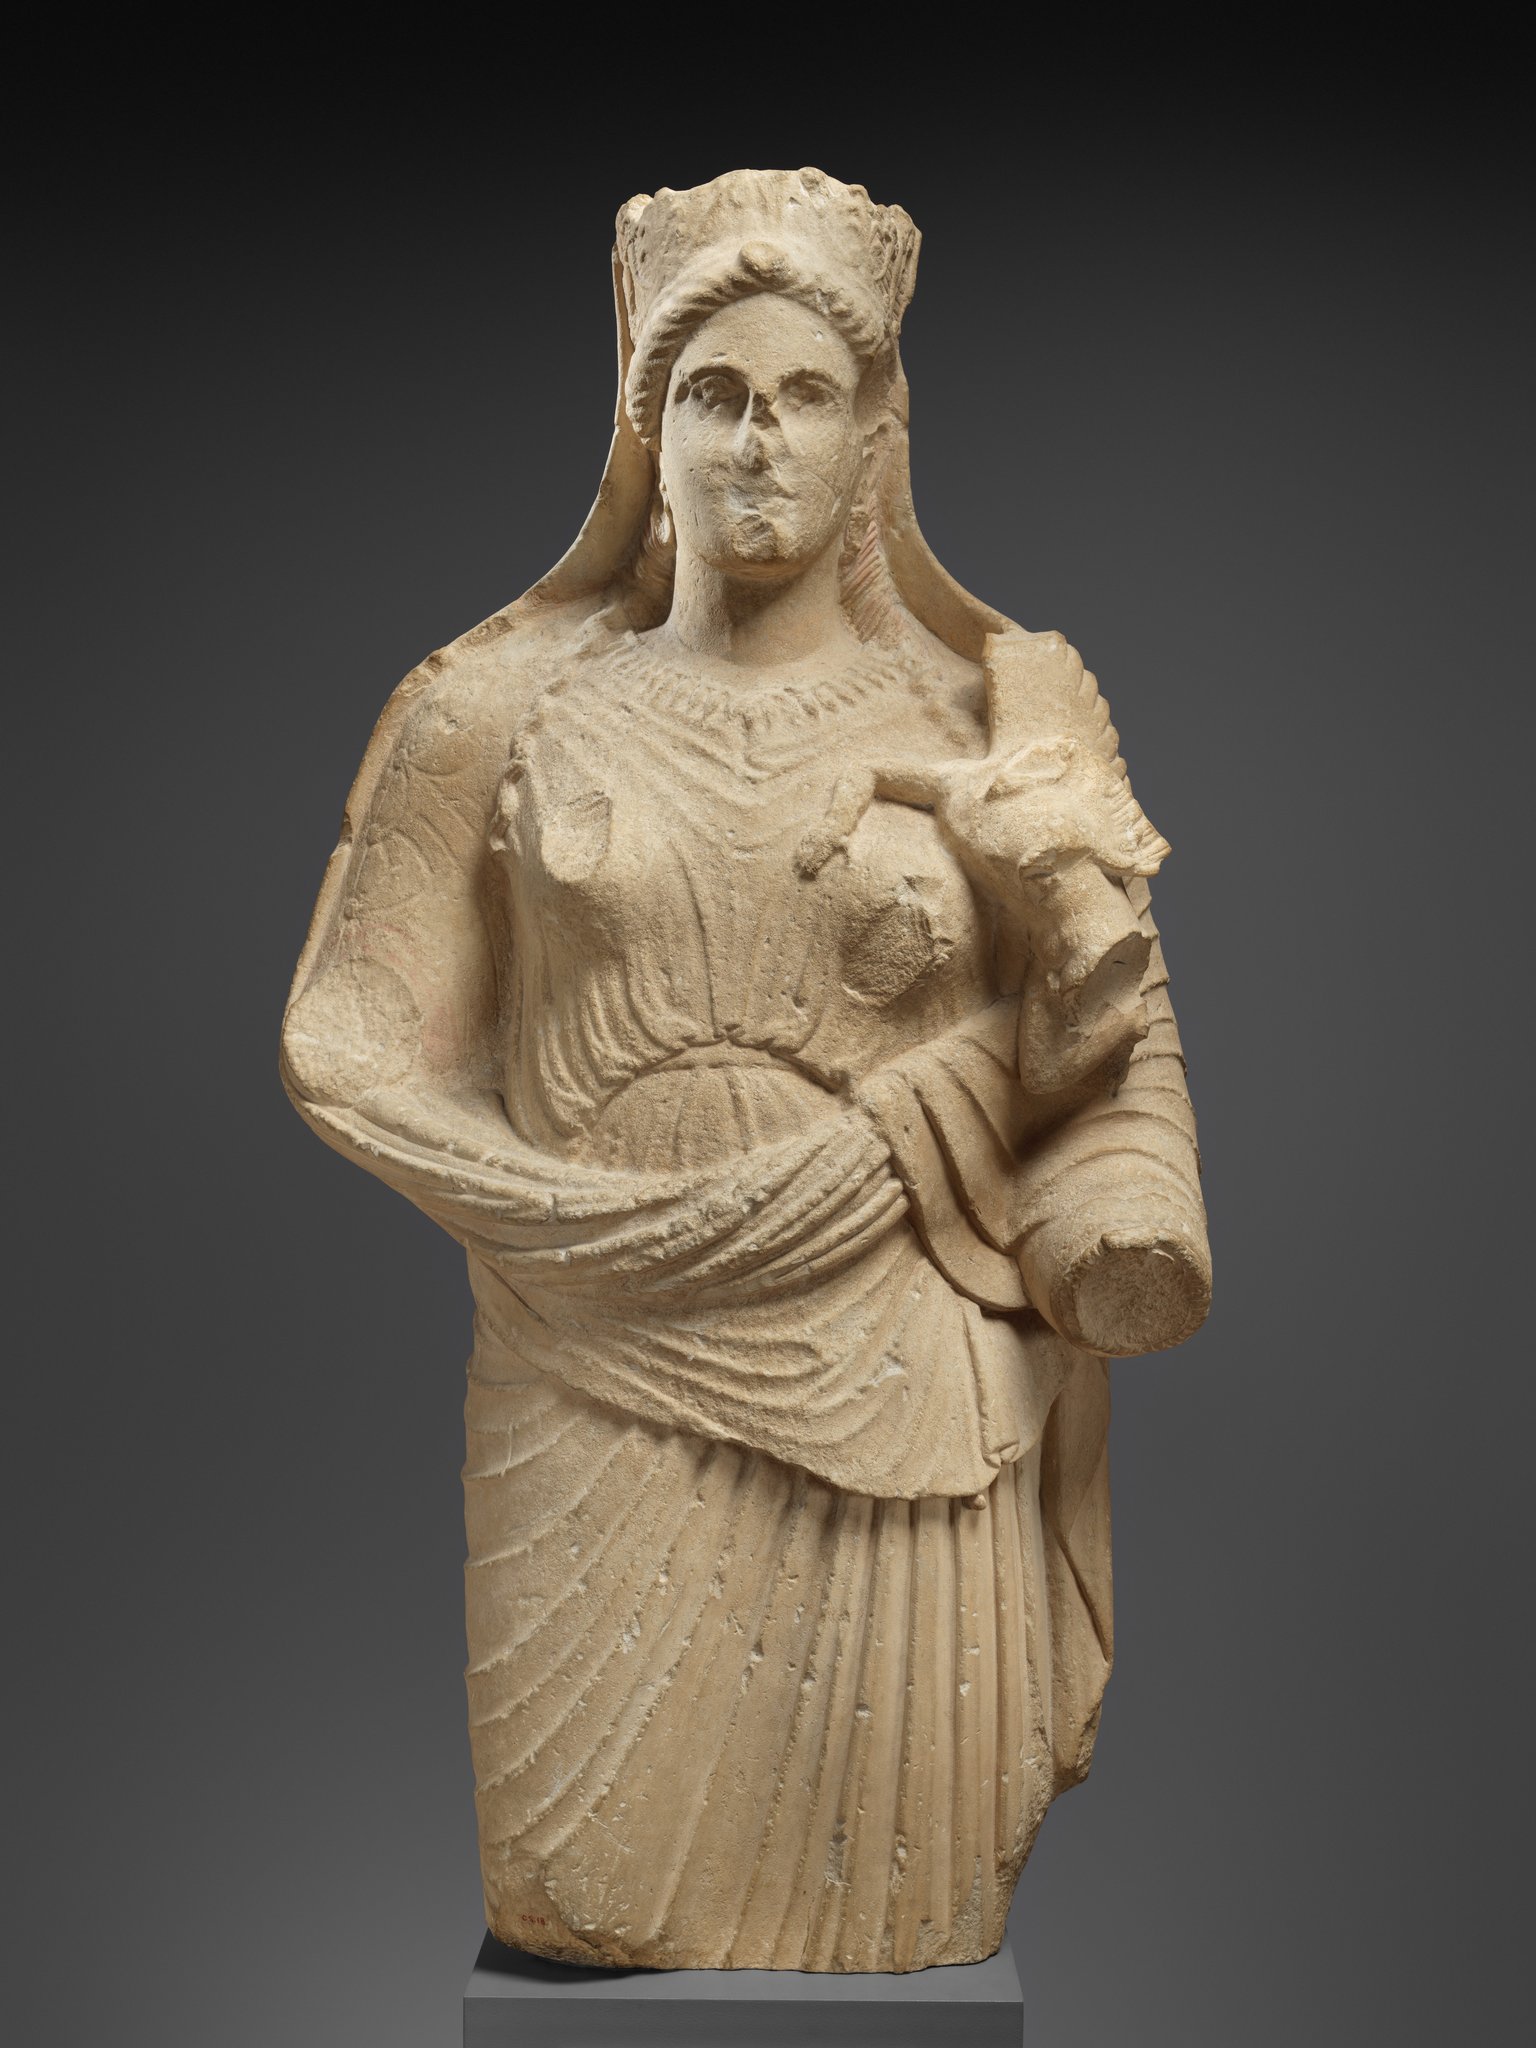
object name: statue of aphrodite with eros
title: Limestone statue of Aphrodite holding winged Eros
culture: cypriot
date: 334-301 BCE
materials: limestone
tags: aphrodite,eros